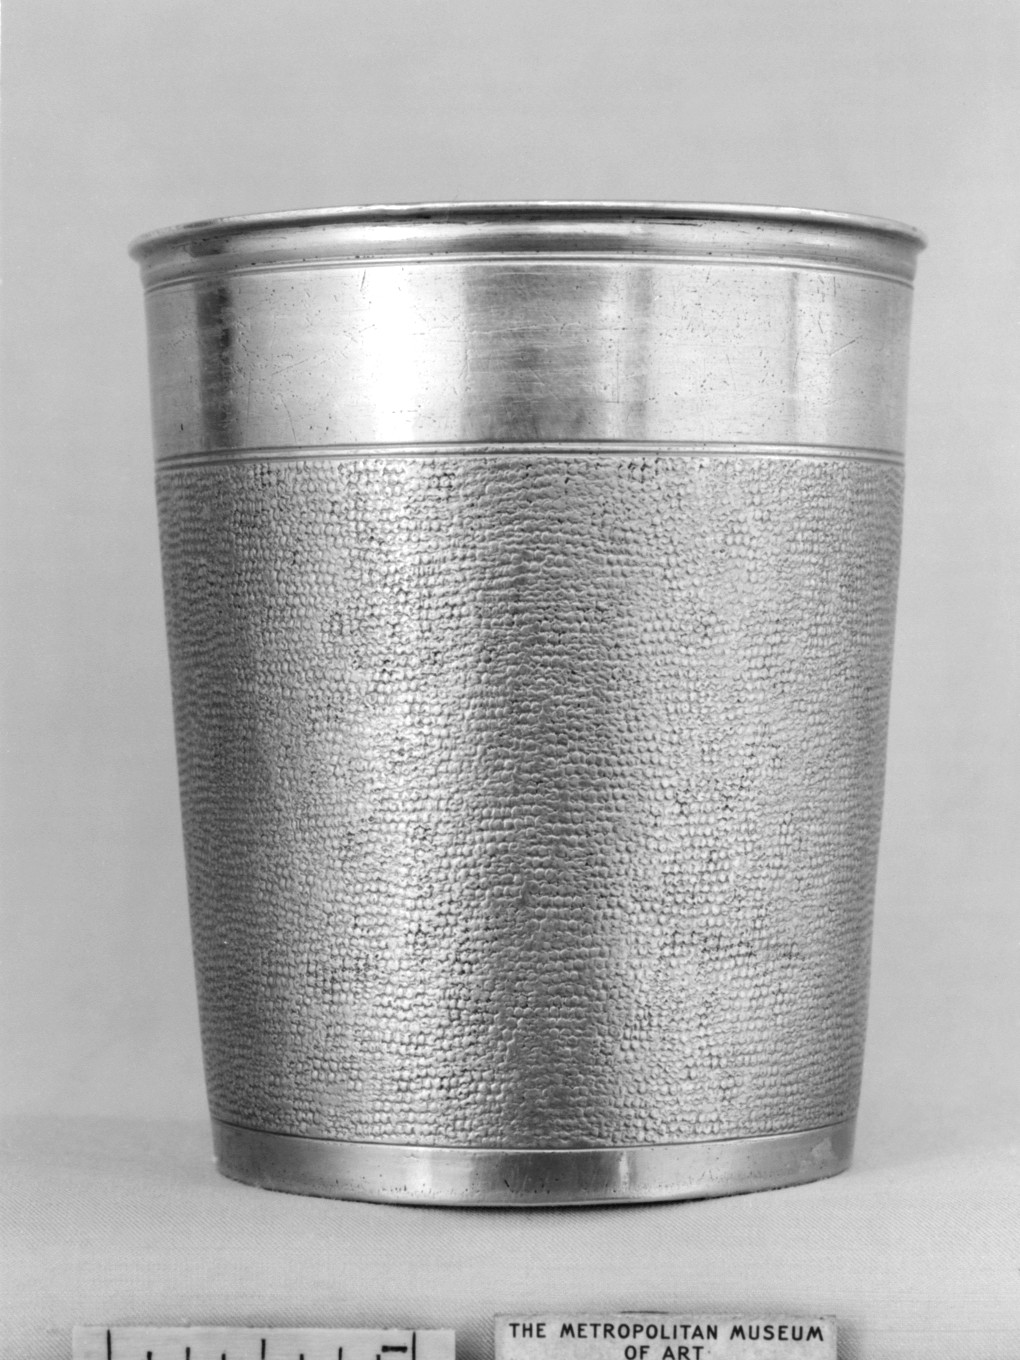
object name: beaker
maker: samuel schneeweiss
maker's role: maker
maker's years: 1597-1697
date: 1670-1675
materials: silver gilt